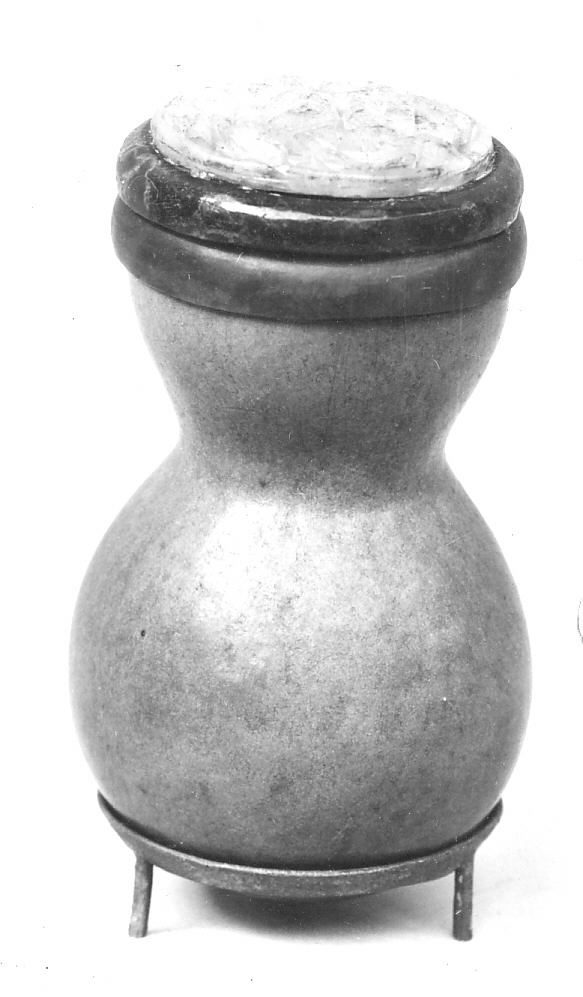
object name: cricket cage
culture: chinese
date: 1701-1900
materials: jade